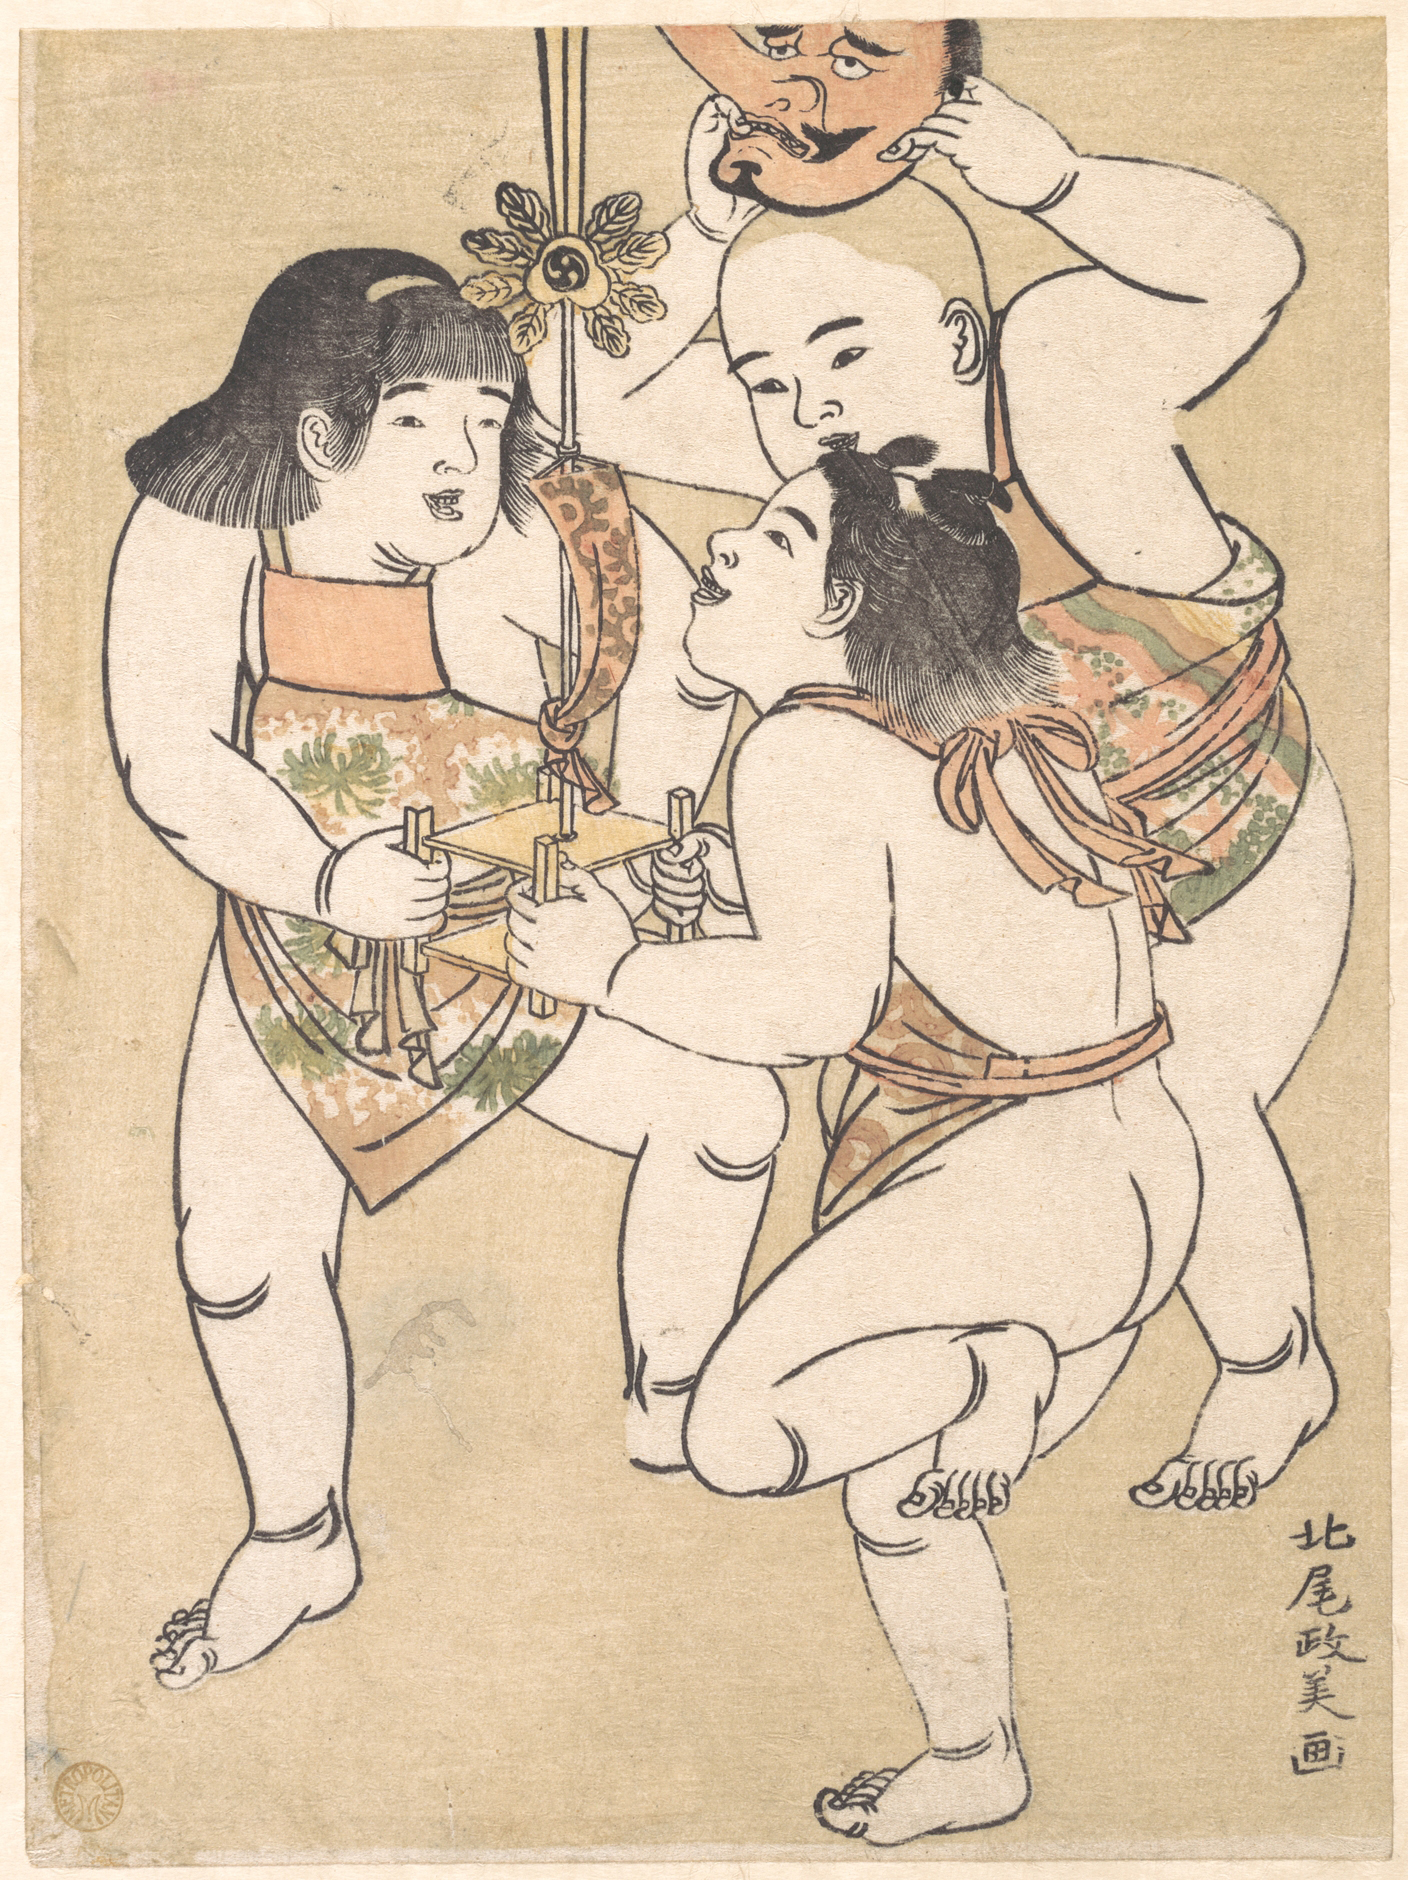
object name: print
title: Children in the Sanno Festival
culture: japanese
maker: kuwagata keisai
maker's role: artist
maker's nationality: japanese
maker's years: 1764-1824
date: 1790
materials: ink, paper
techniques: woodblock print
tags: boys,girls